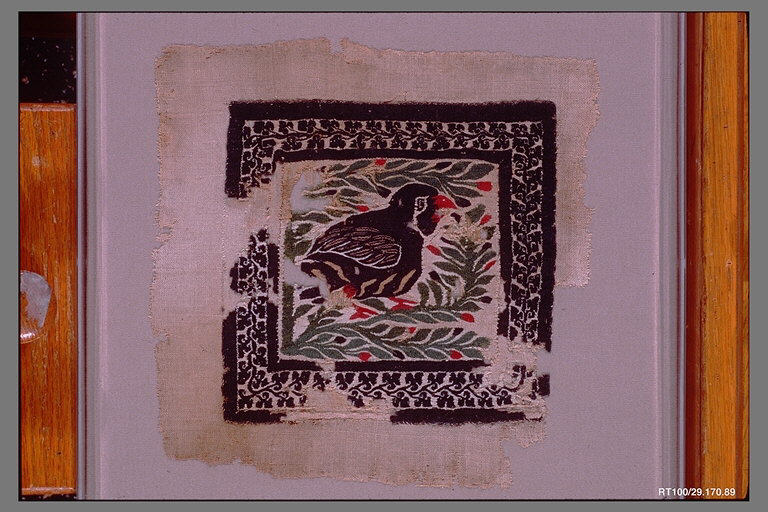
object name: textile fragment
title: Square with Quail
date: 401-500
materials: linen, wool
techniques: weave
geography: egypt